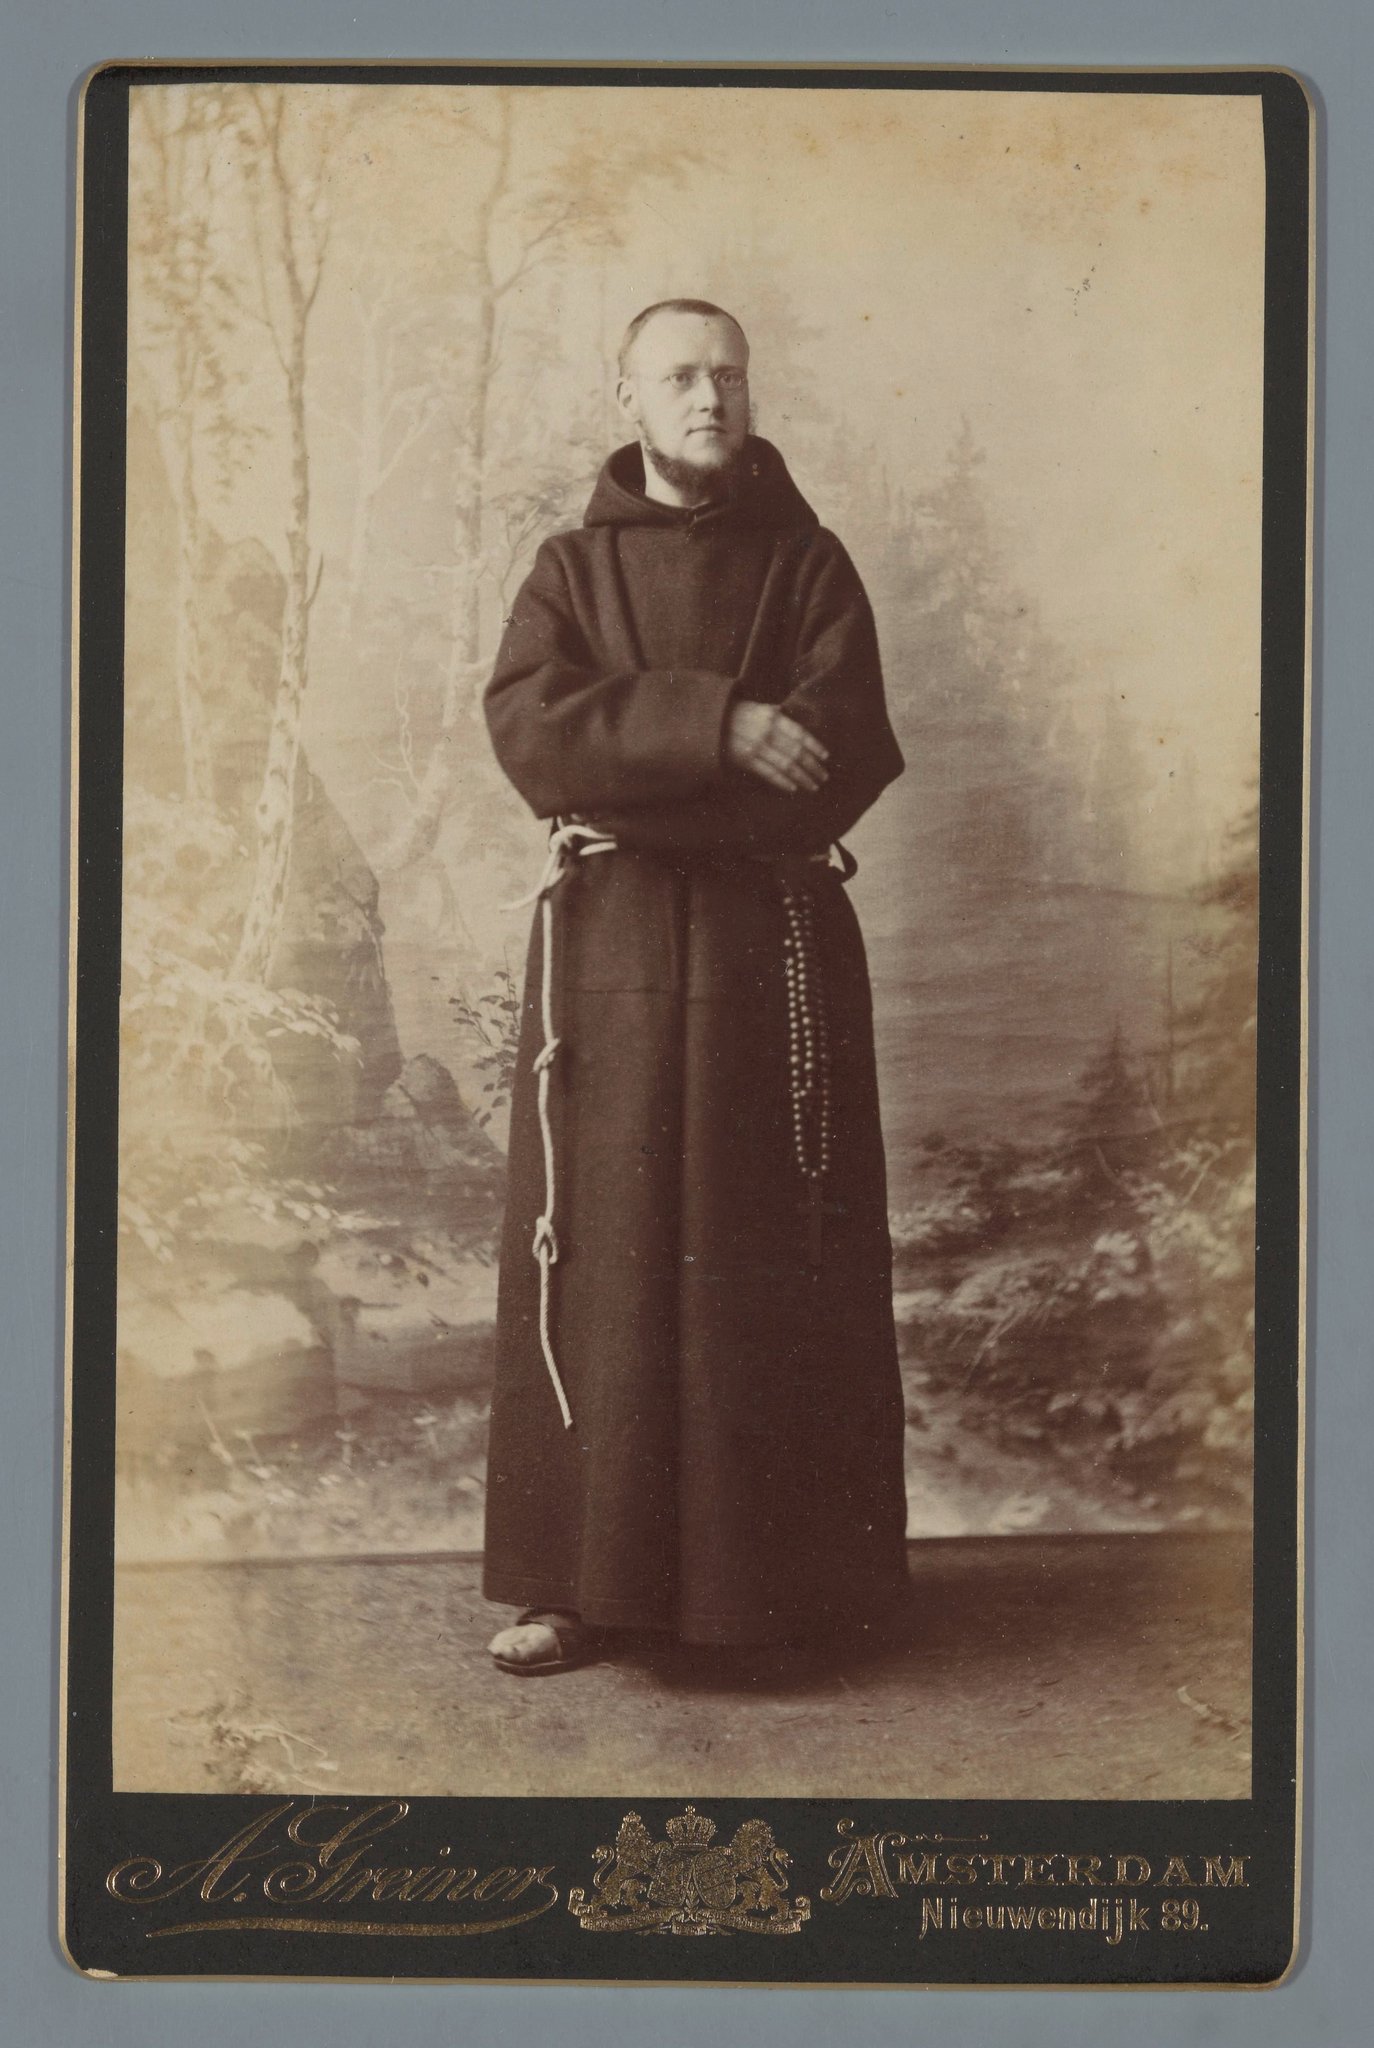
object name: cabinet photograph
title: Portret van een monnik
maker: albert greiner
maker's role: fotograaf, fotostudio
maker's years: 1833-1890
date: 1861-1890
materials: cardboard, photographic support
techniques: albumen print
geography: amsterdam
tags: studio requisites ~ photographer, monk(s), friar(s)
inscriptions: name: ‘Albert Greiner Kon.Ned. Hof-Photograaf Amsterdam Nieuwendijk 89. (...)’